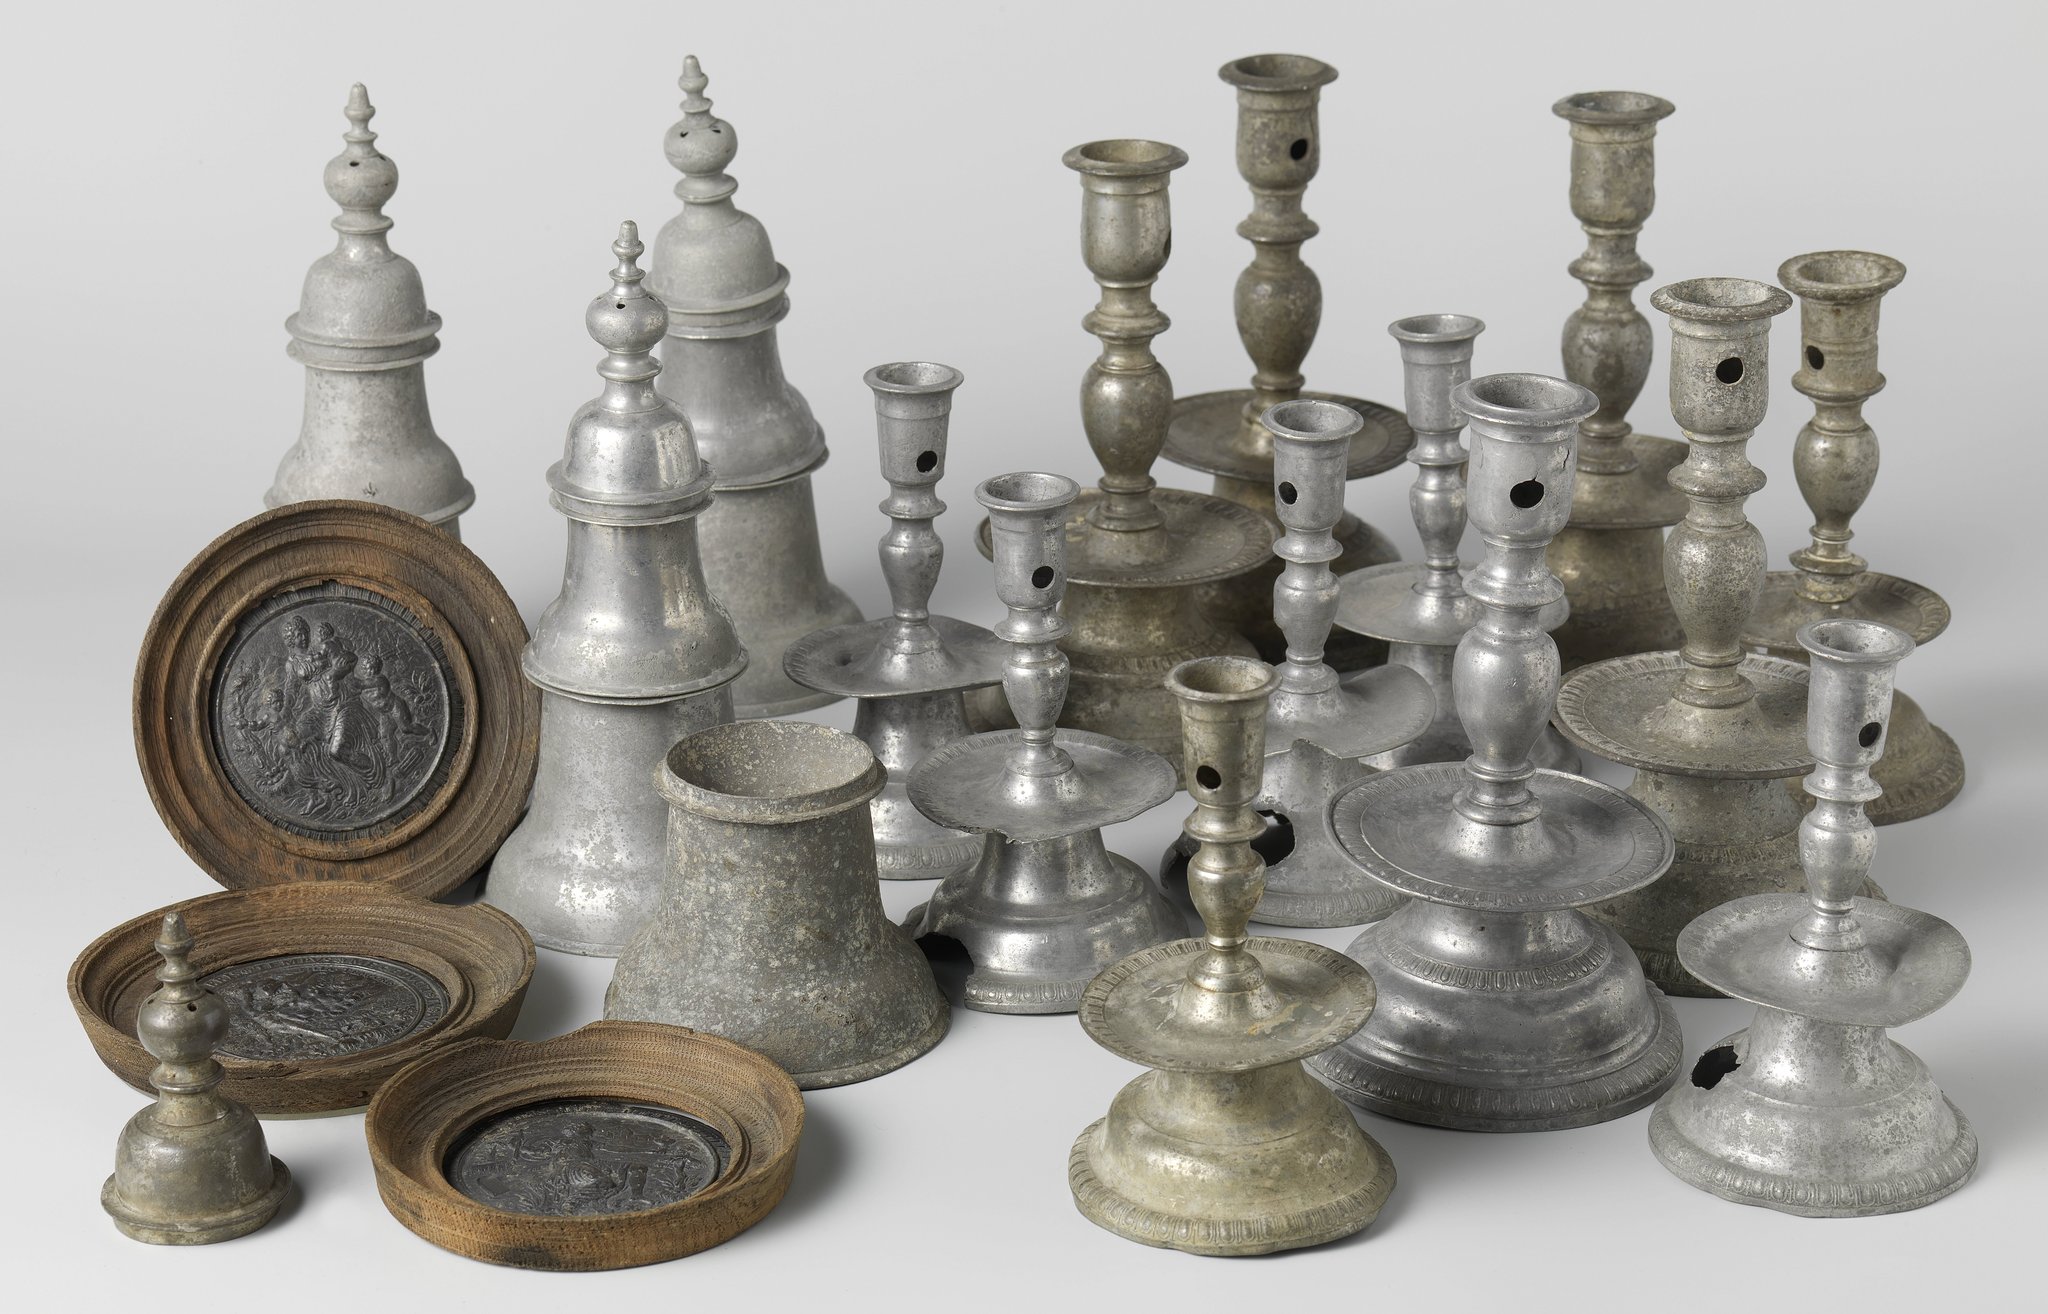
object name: salt condiment vessel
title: Bus van tin, fragment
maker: Anonymous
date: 1590-1596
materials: tin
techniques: casting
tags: willem barendsz., amsterdam, jacob van heemskerck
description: Tinnen bus of vat waarvan alleen de kroes bewaard is gebleven.